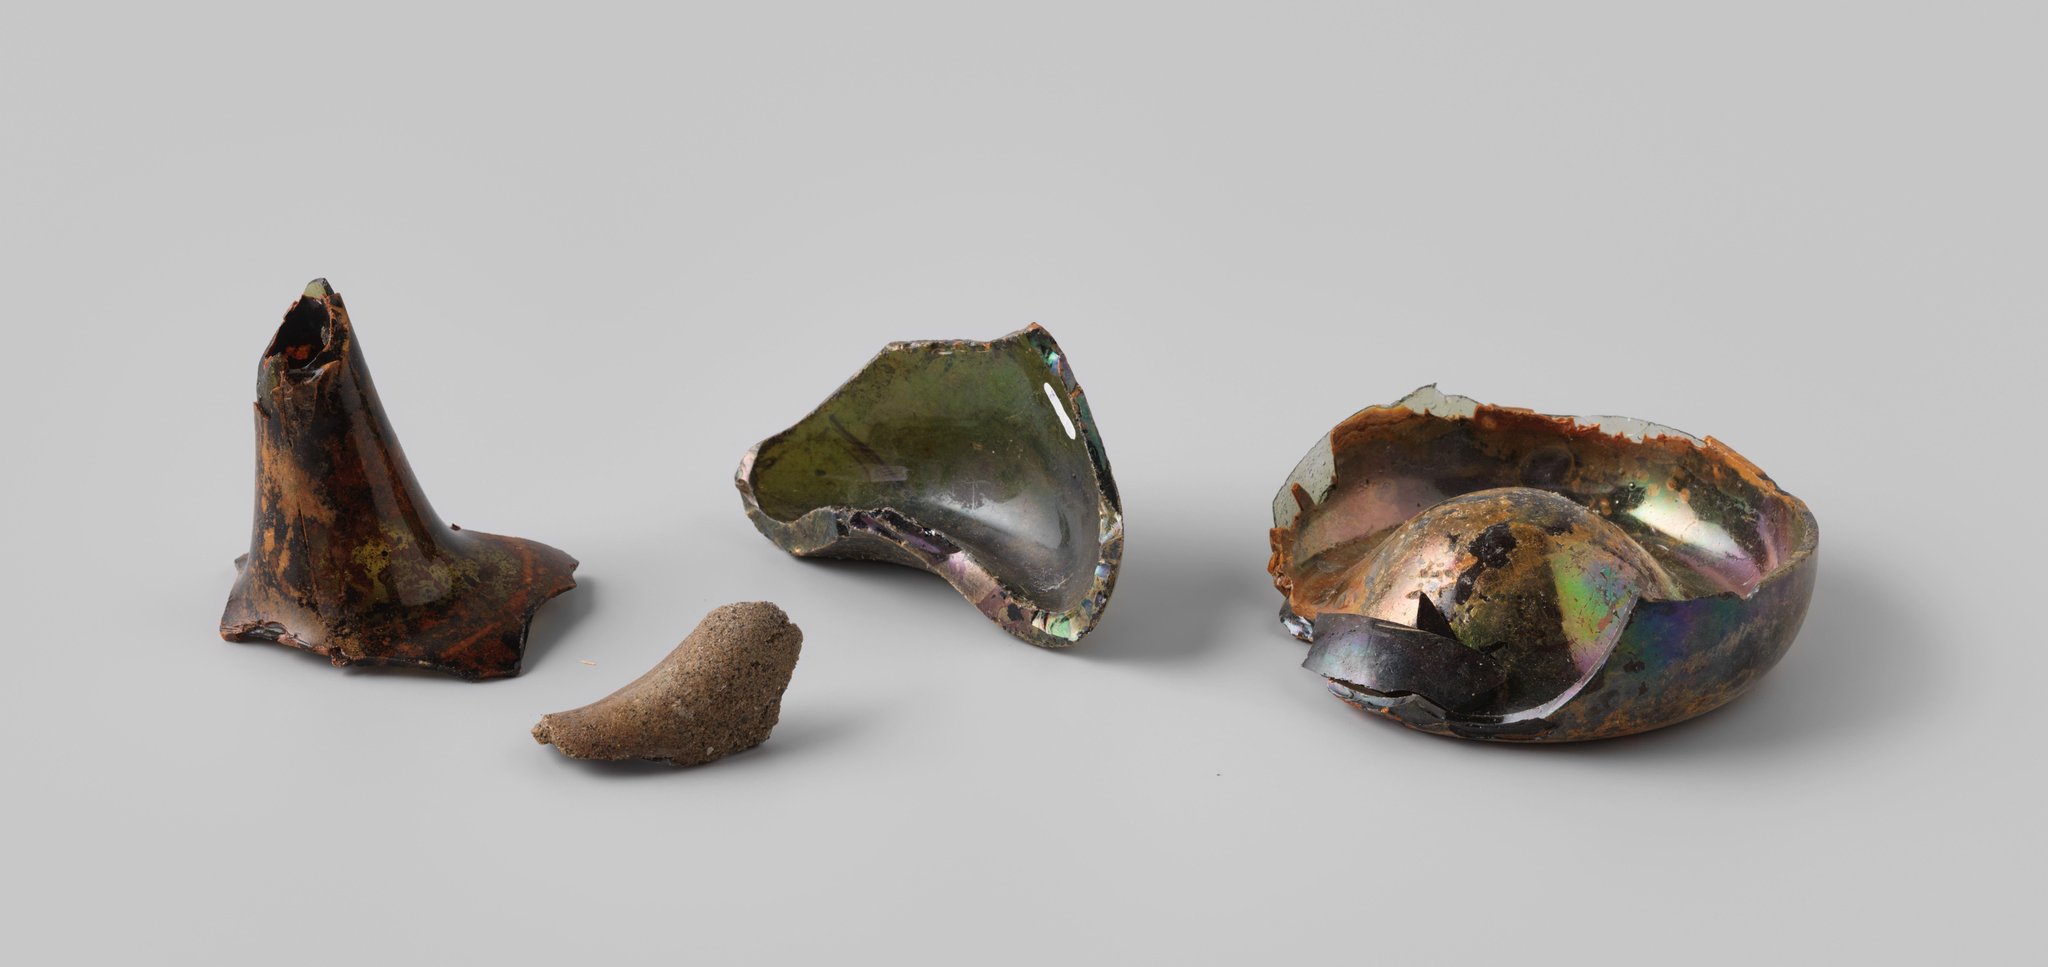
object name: sherd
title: Scherven van wijnflessen uit het wrak van de Oost-Indiëvaarder 't Vliegend Hart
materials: glass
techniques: green glass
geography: netherlands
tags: 't vliegend hart (schip), verenigde oostindische compagnie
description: Scherven van uivormige wijnflessen van groen glas waar rode (port)wijn in heeft gezeten. Eén brok van zand in de vorm van de bodem van de fles.